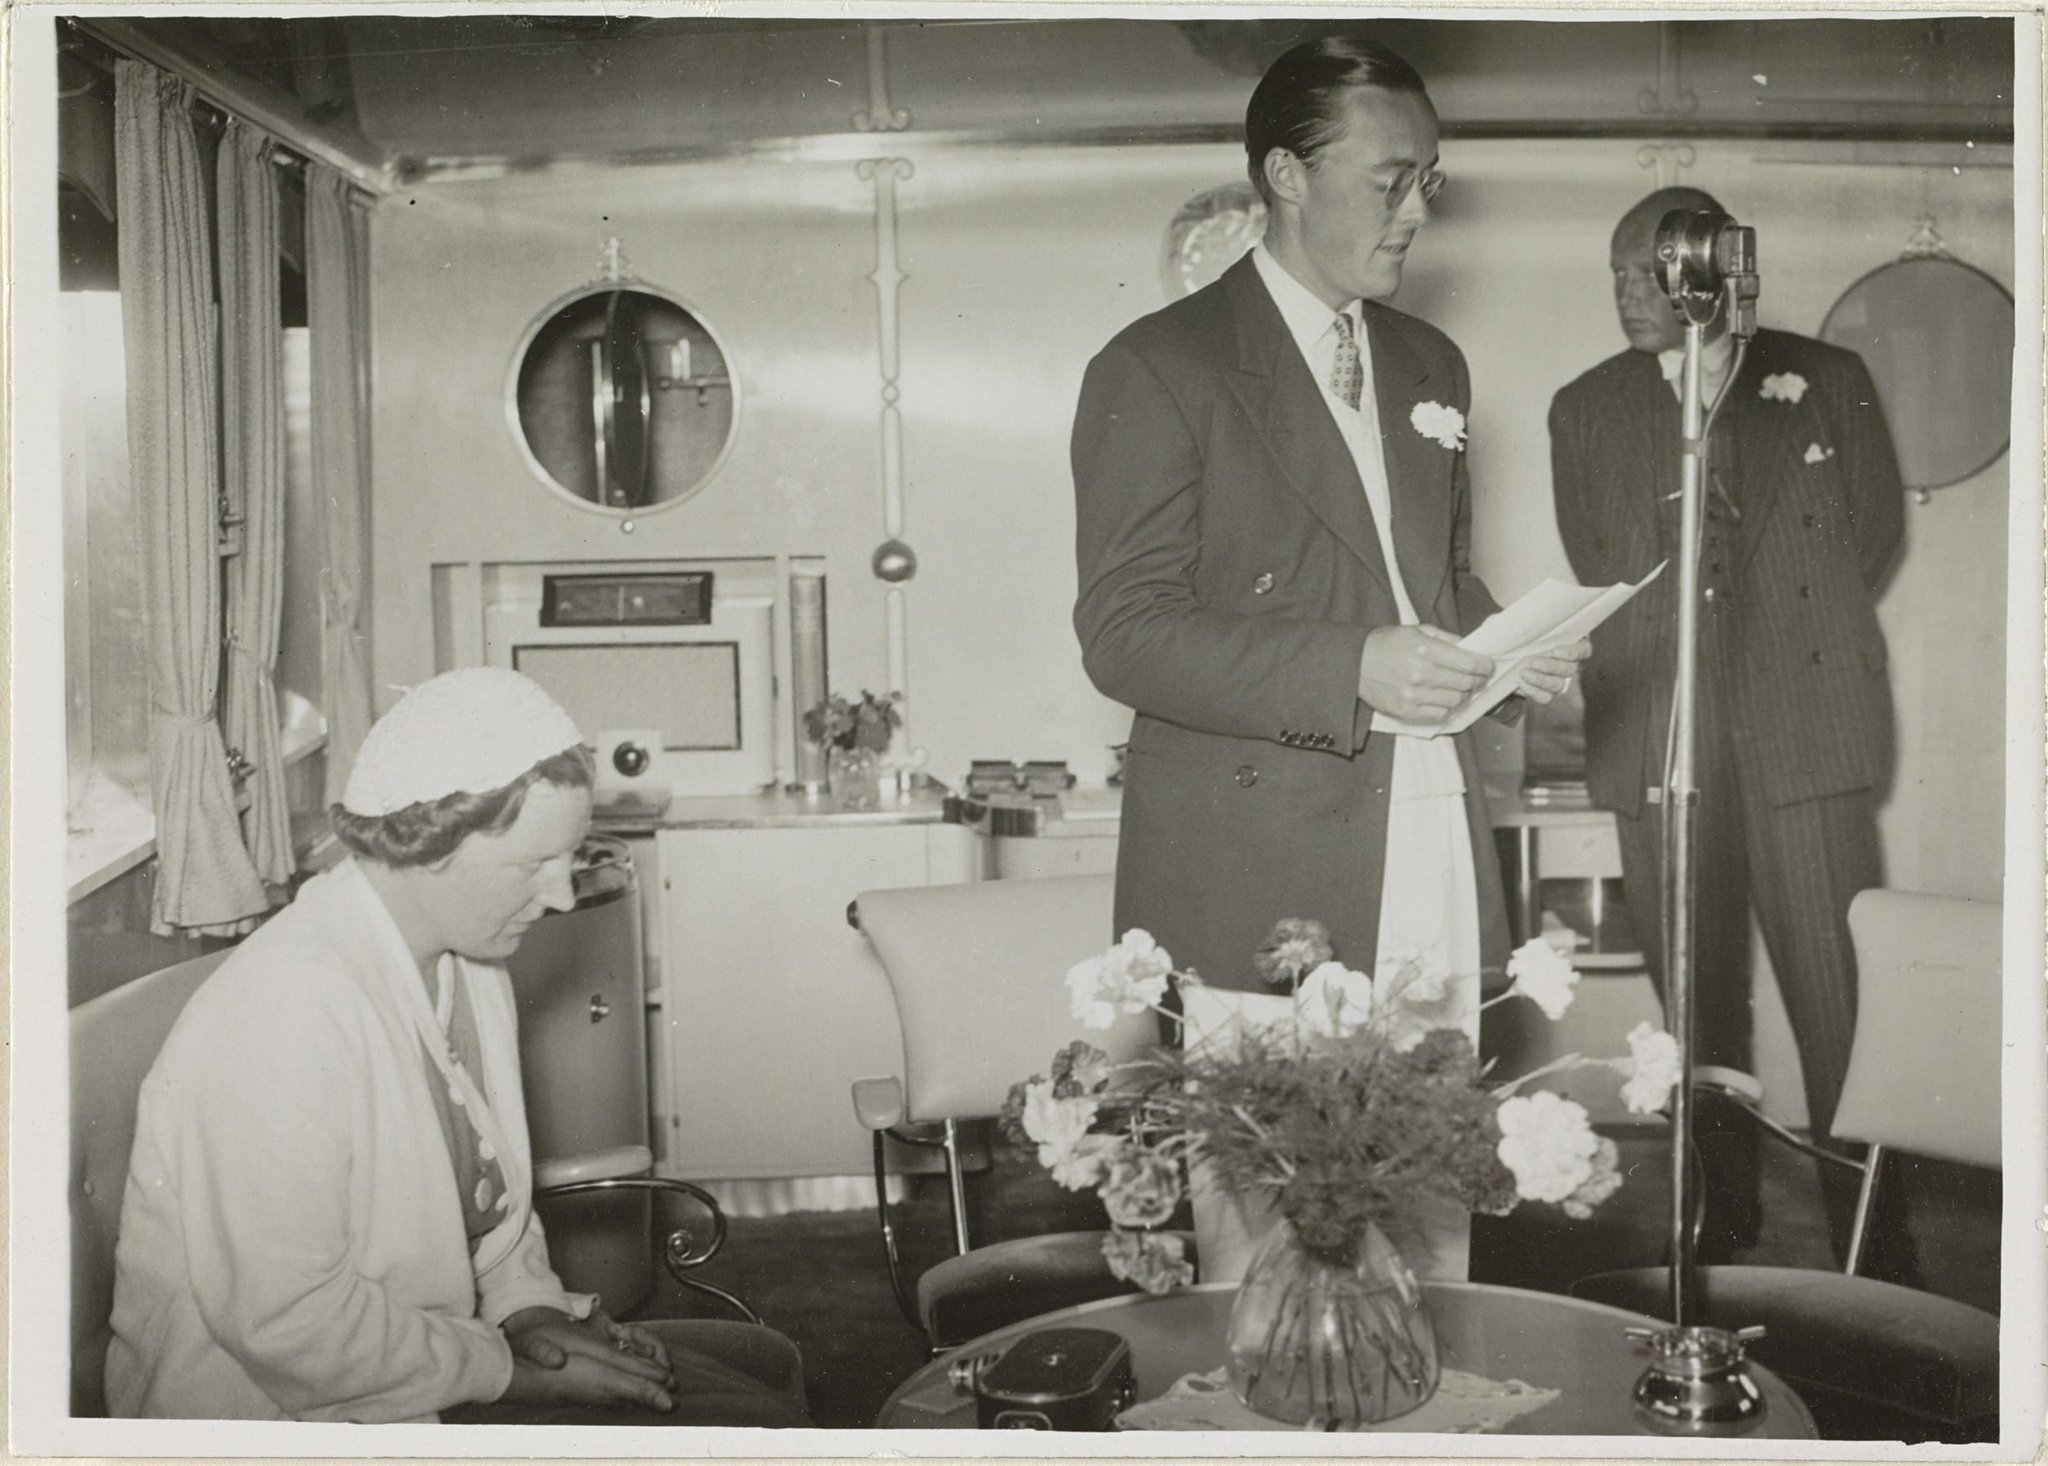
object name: photograph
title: Bezoek van Juliana, koningin der Nederlanden, en Bernhard van Lippe-Biesterfeld aan het prinsenjacht Hr. Ms. 'Piet Hein' te Muiden op 28 augustus 1937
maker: Anonymous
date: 1937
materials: photographic support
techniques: photography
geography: netherlands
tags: utrecht, bernhard (prins der nederlanden), the hague, juliana of the netherlands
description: De hier vermelde titel verwijst naar de hoogst verkregen titel van de geportretteerde, niet per se naar de titel die de geportretteerde op deze voorstelling draagt.